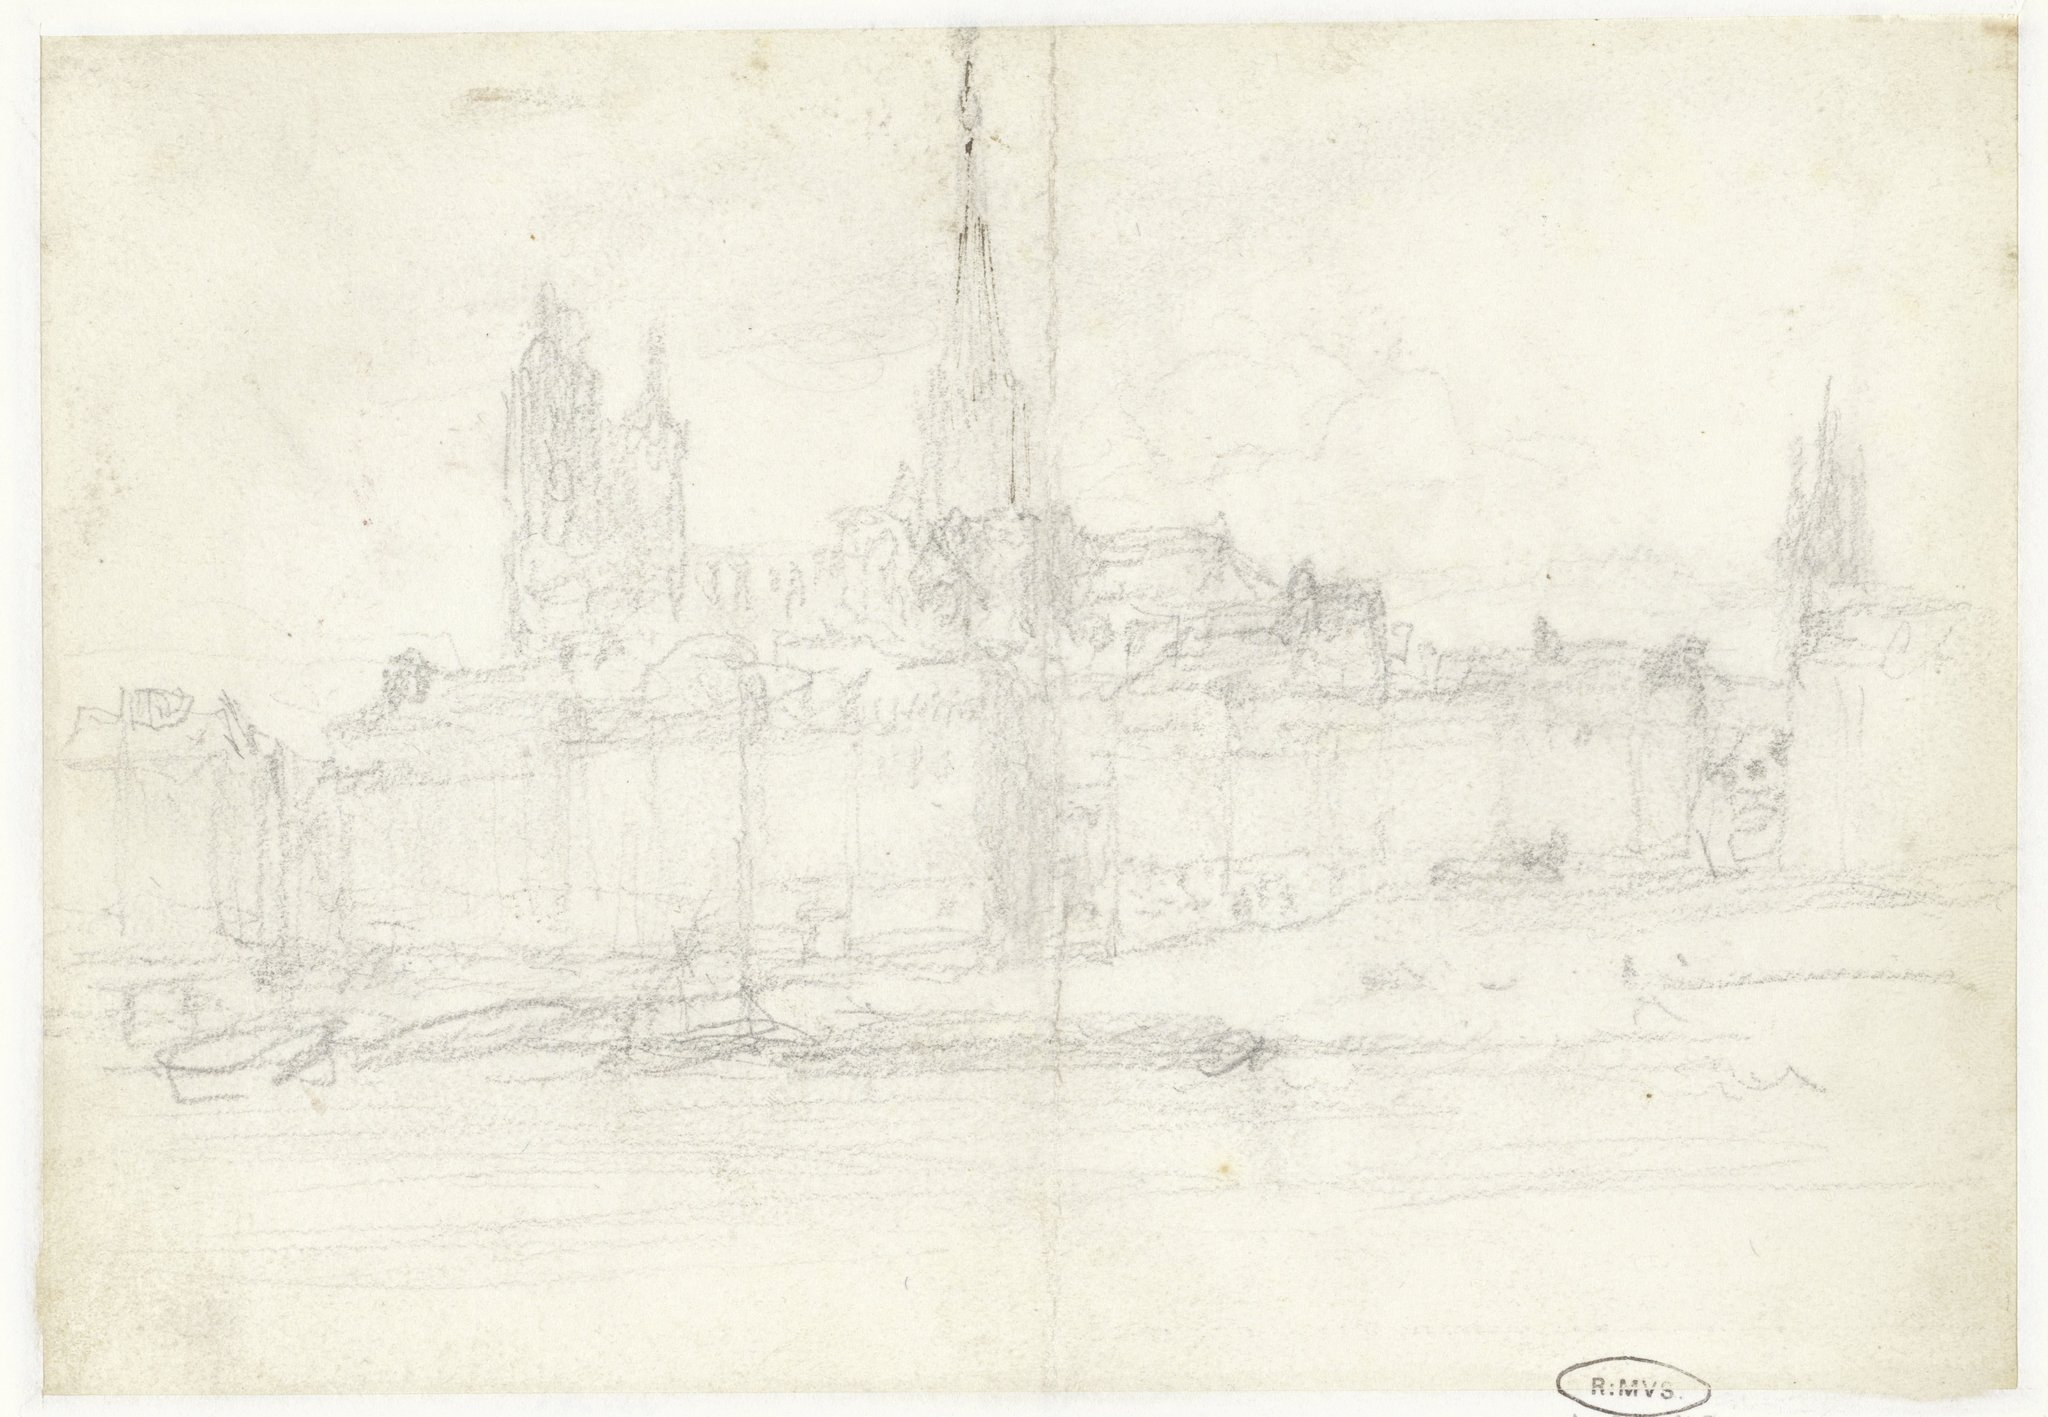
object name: drawing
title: View of Rouen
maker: matthijs maris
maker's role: draughtsman, painter, print maker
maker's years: 1839-1917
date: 1869-1872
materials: chalk, paper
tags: public road